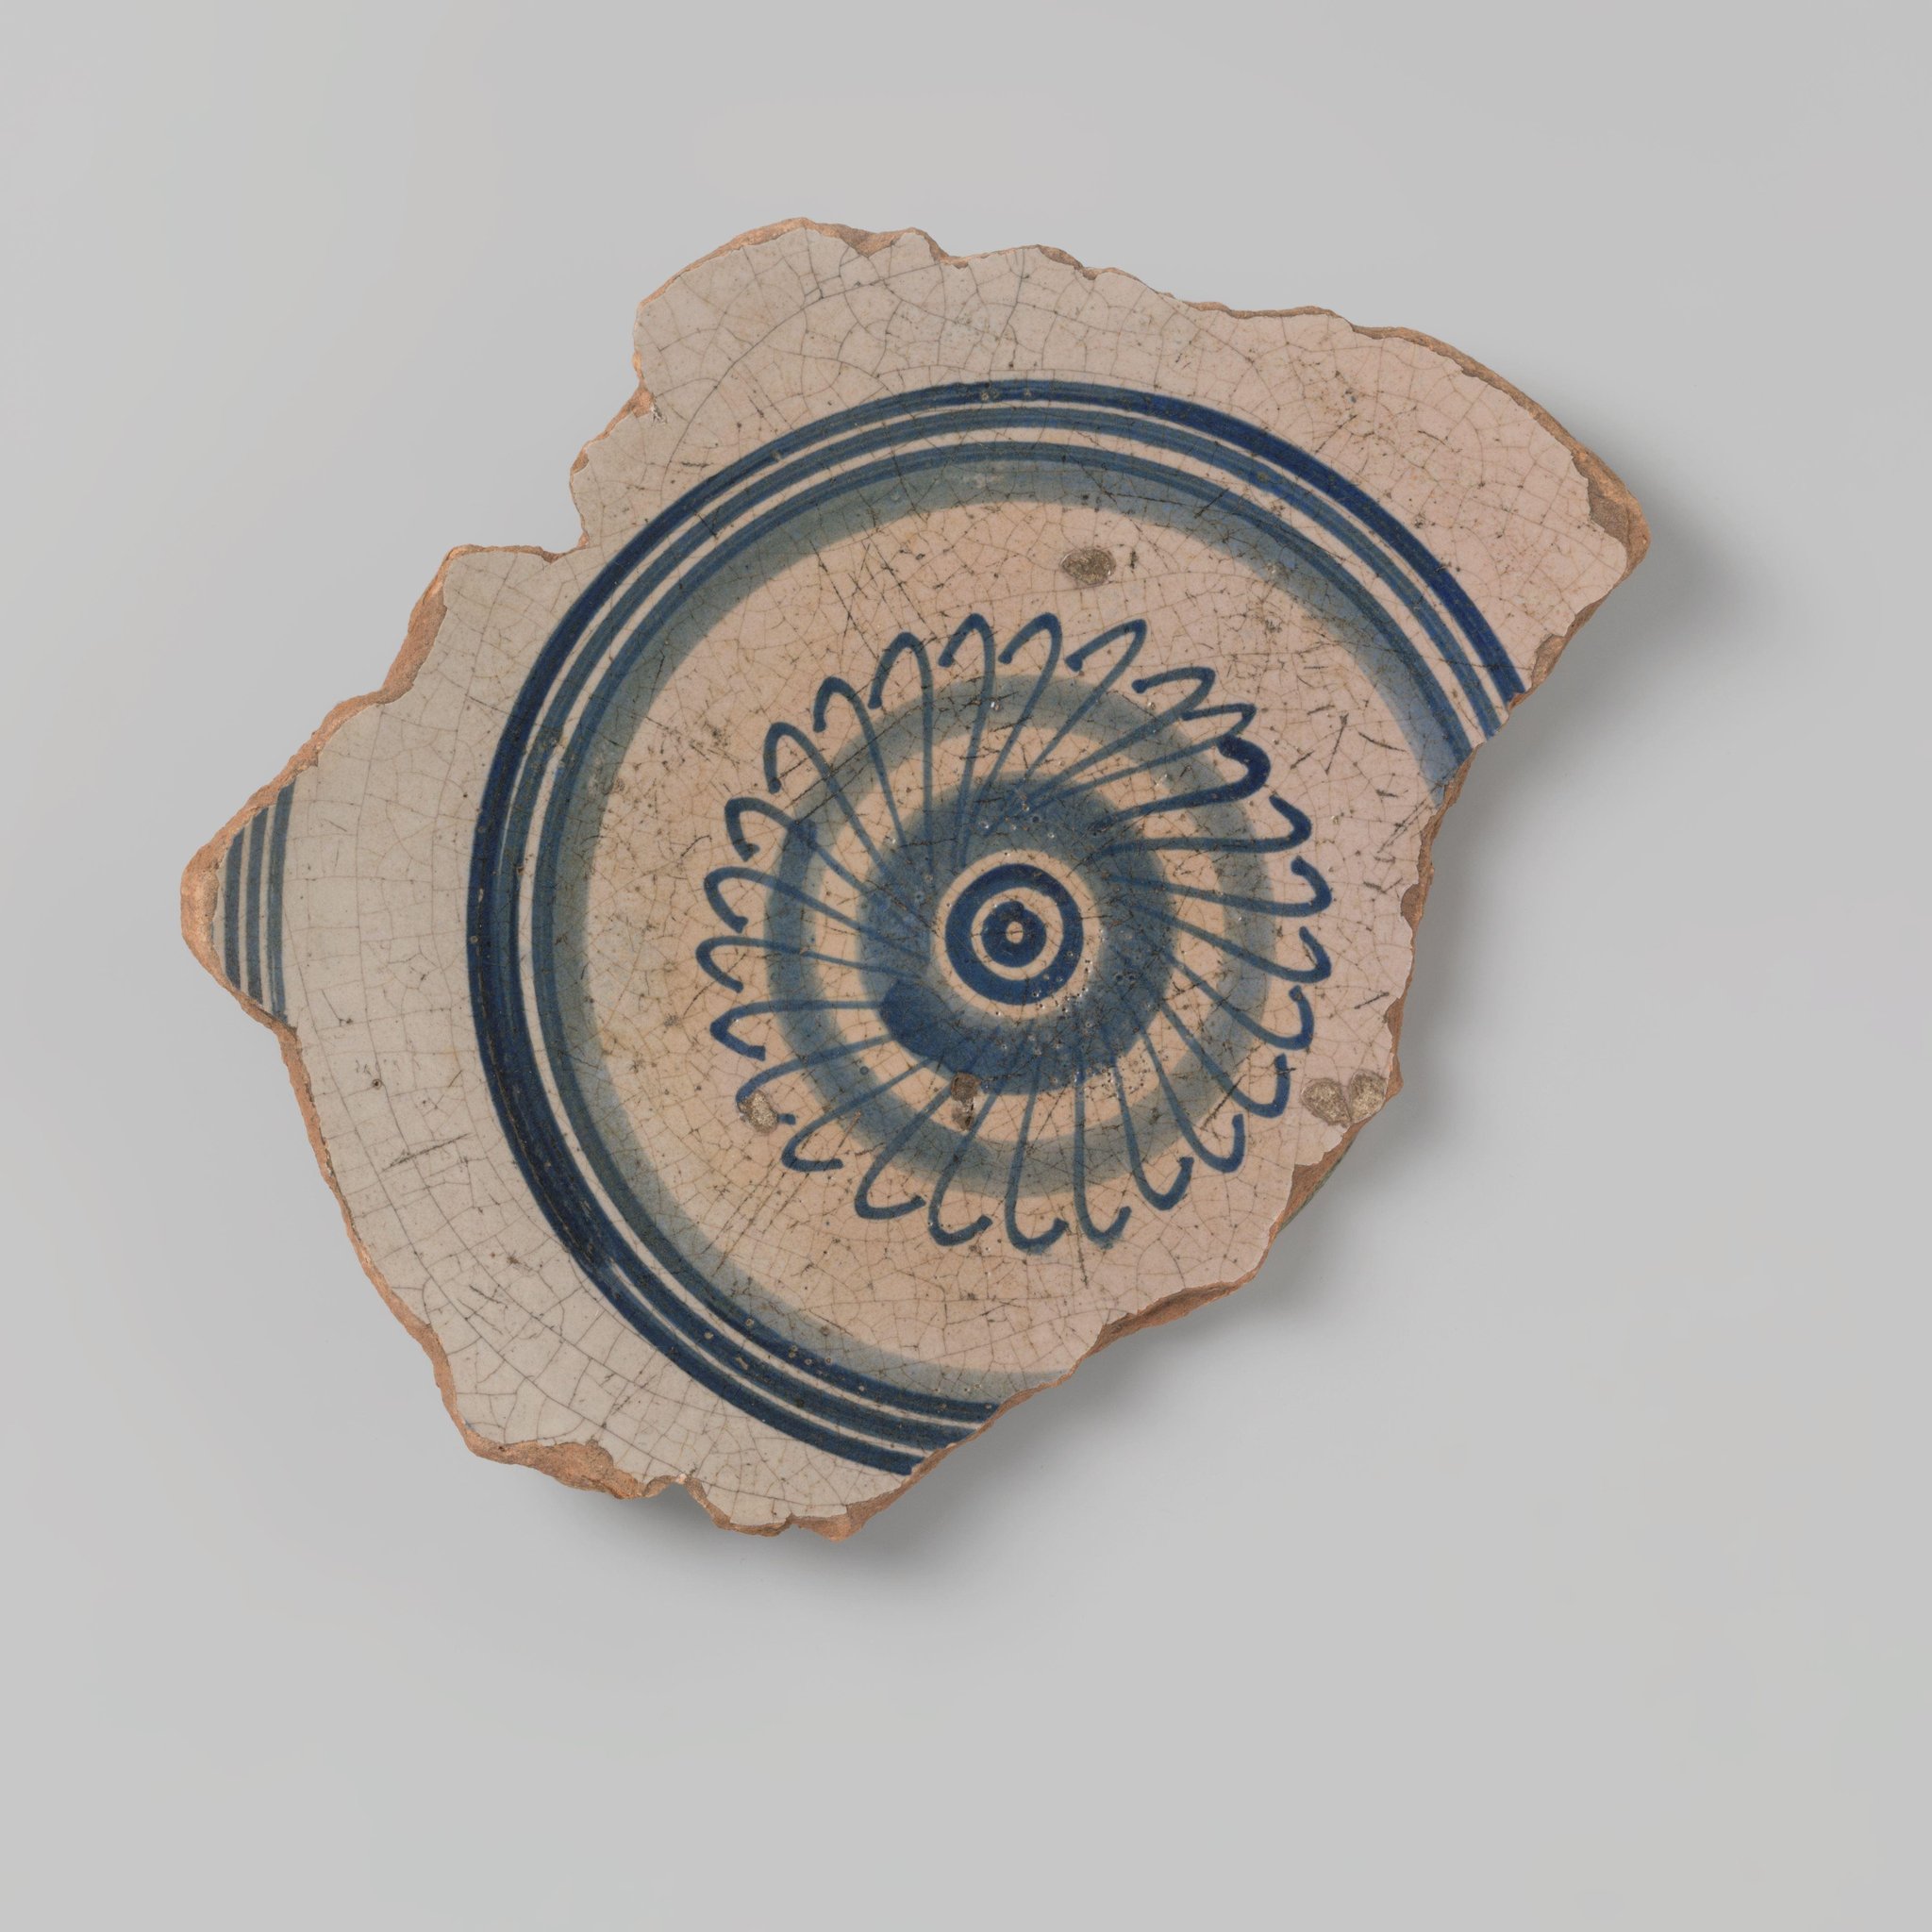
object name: sherd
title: Schotelscherf van aardewerk met tekening van een bloem in een cirkel, in onderglazuur blauw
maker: Anonymous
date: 1500-1799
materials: earthenware, glaze